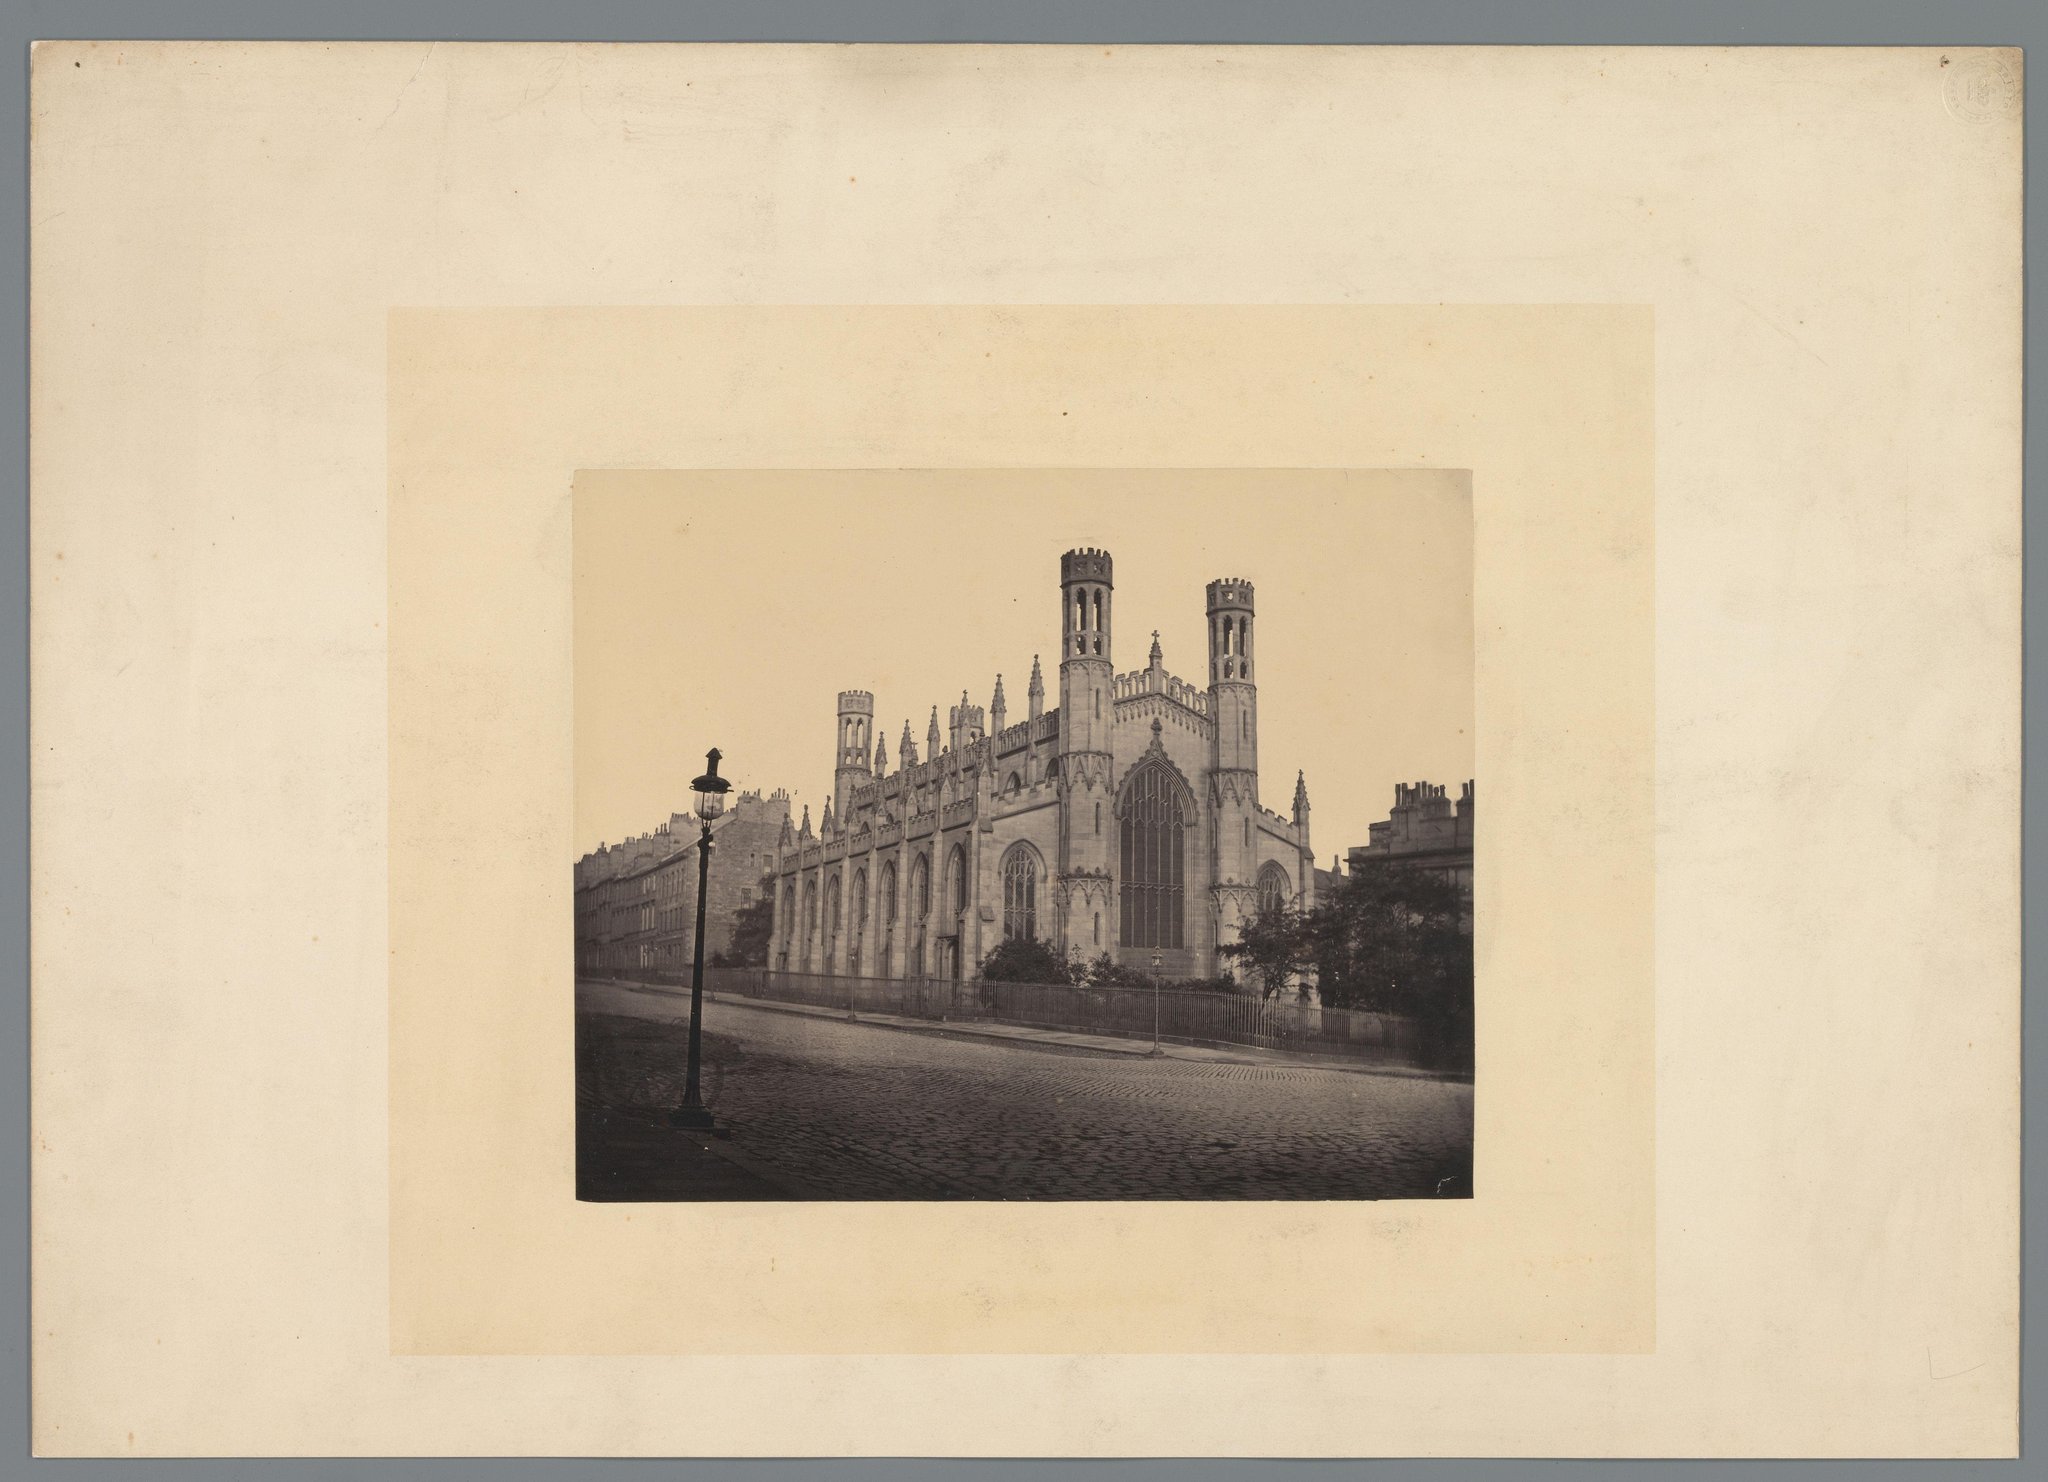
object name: photograph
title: Gezicht op kathedraal te Engeland met lantaarnpaal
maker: Anonymous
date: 1855-1865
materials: cardboard, paper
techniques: albumen print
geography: england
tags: england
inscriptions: inscription: ‘BRISTOL/ BOARD’